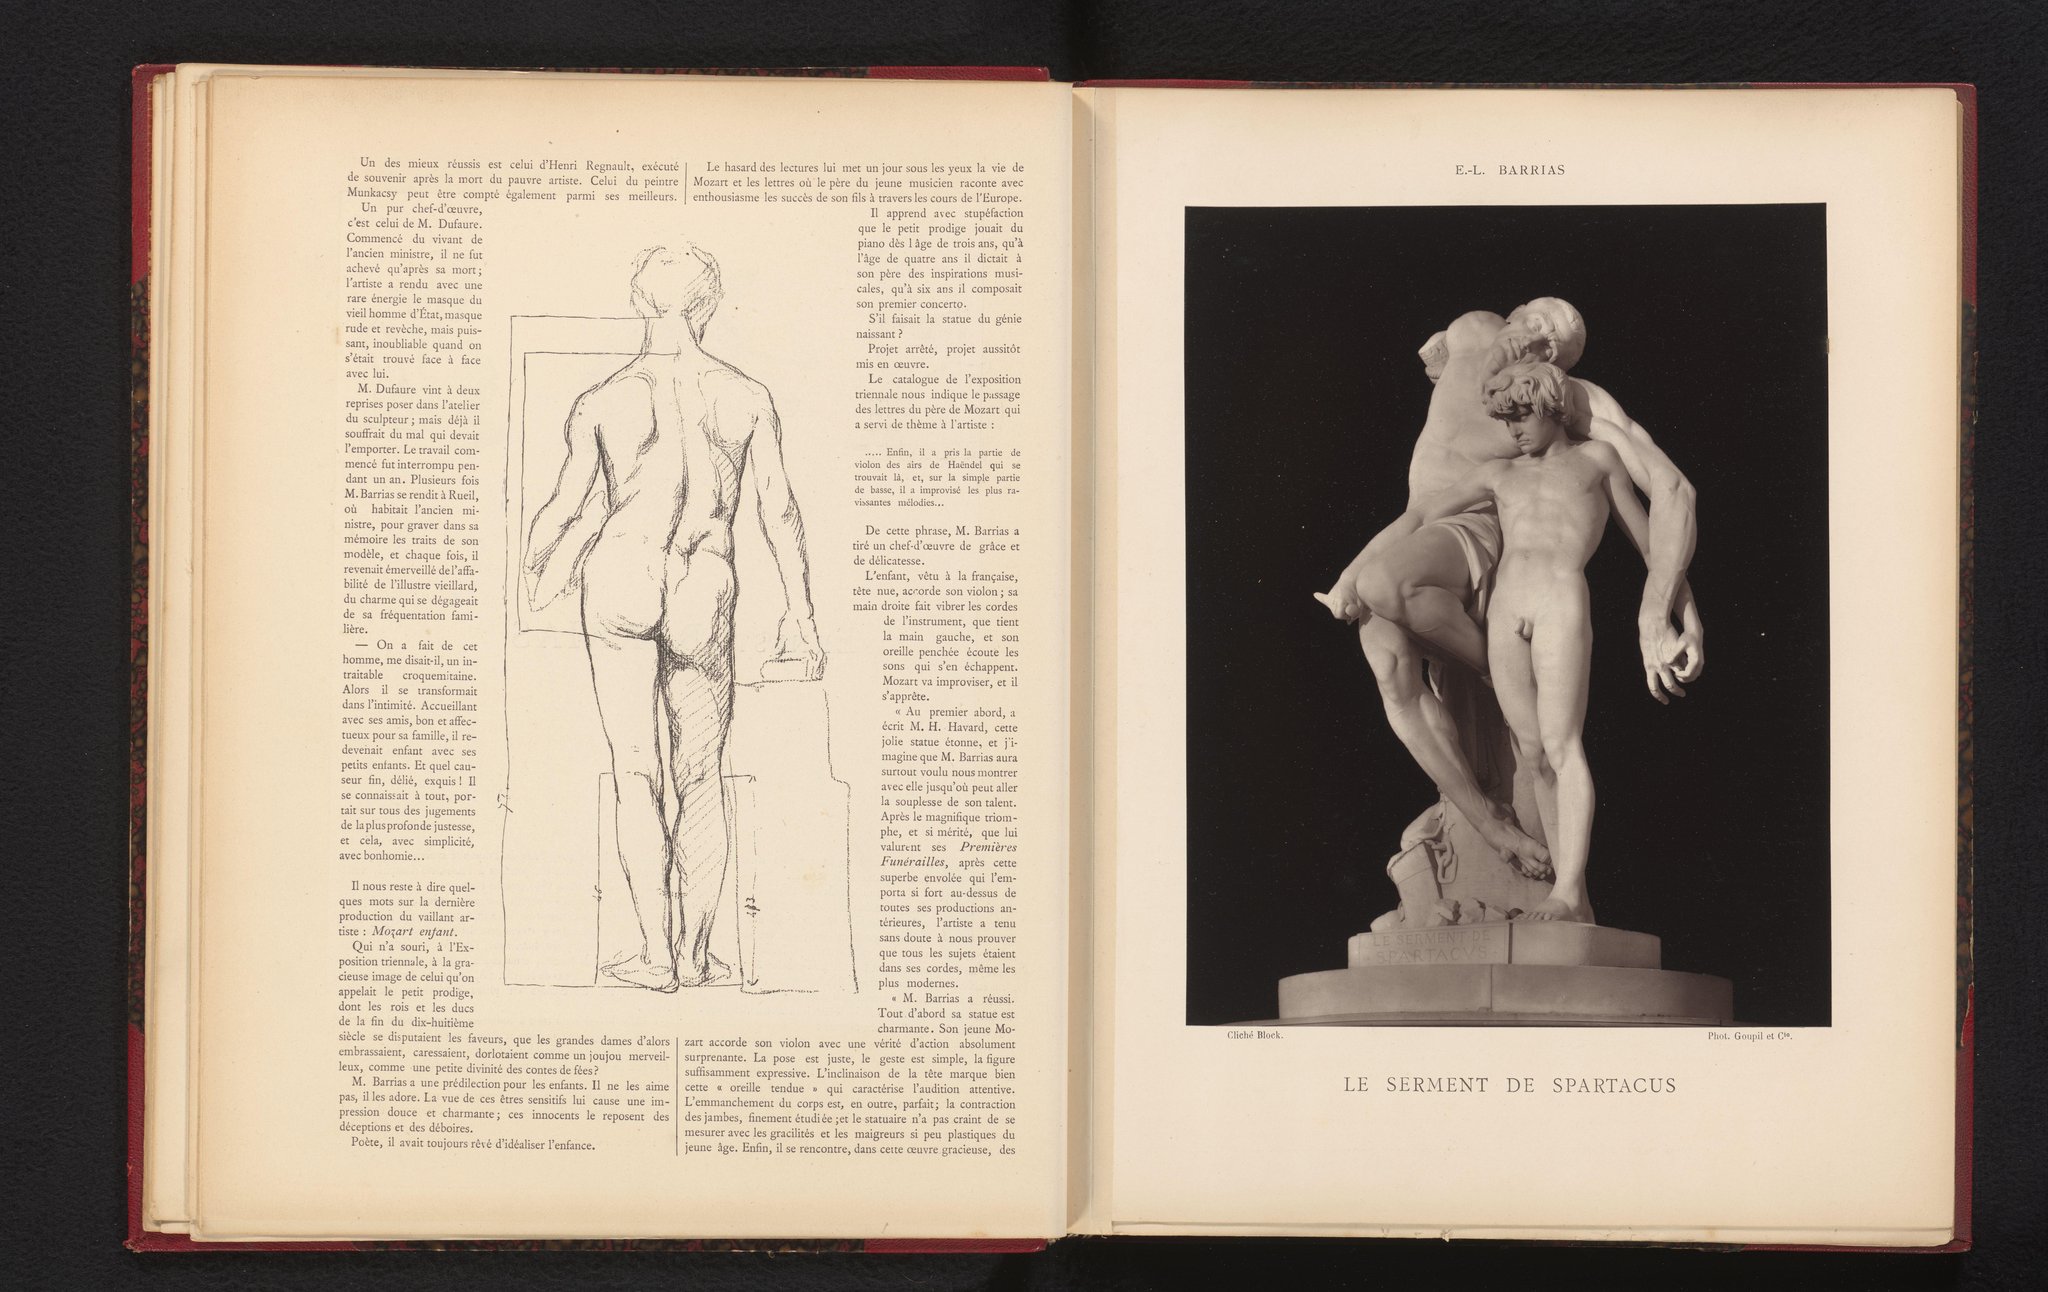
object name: page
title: Sculptuur 'Le serment de Spartacus' door Louis-Ernest Barrias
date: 1879-1884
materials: paper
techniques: woodburytype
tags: adult man